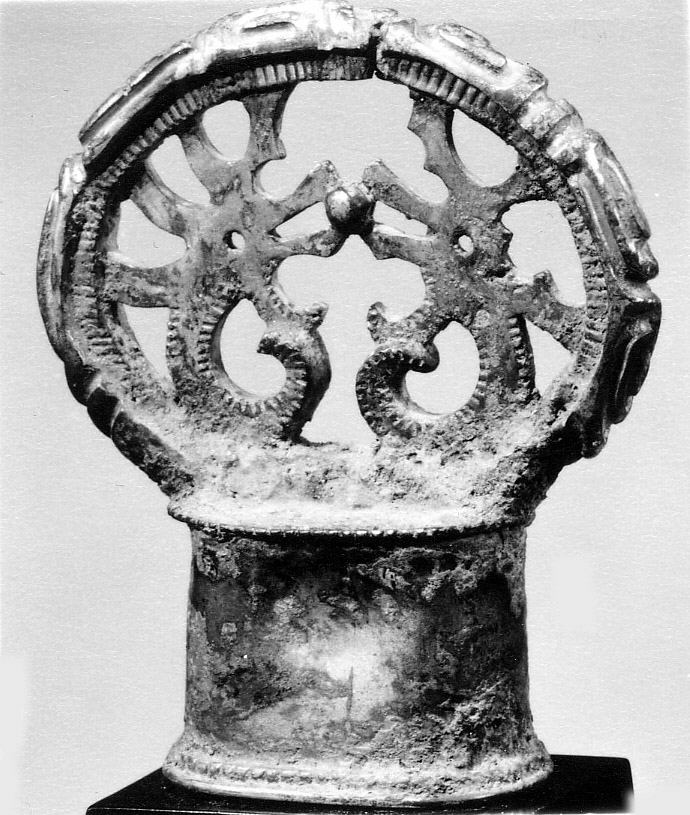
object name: sword handle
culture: japanese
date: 501-600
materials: bronze, gilt